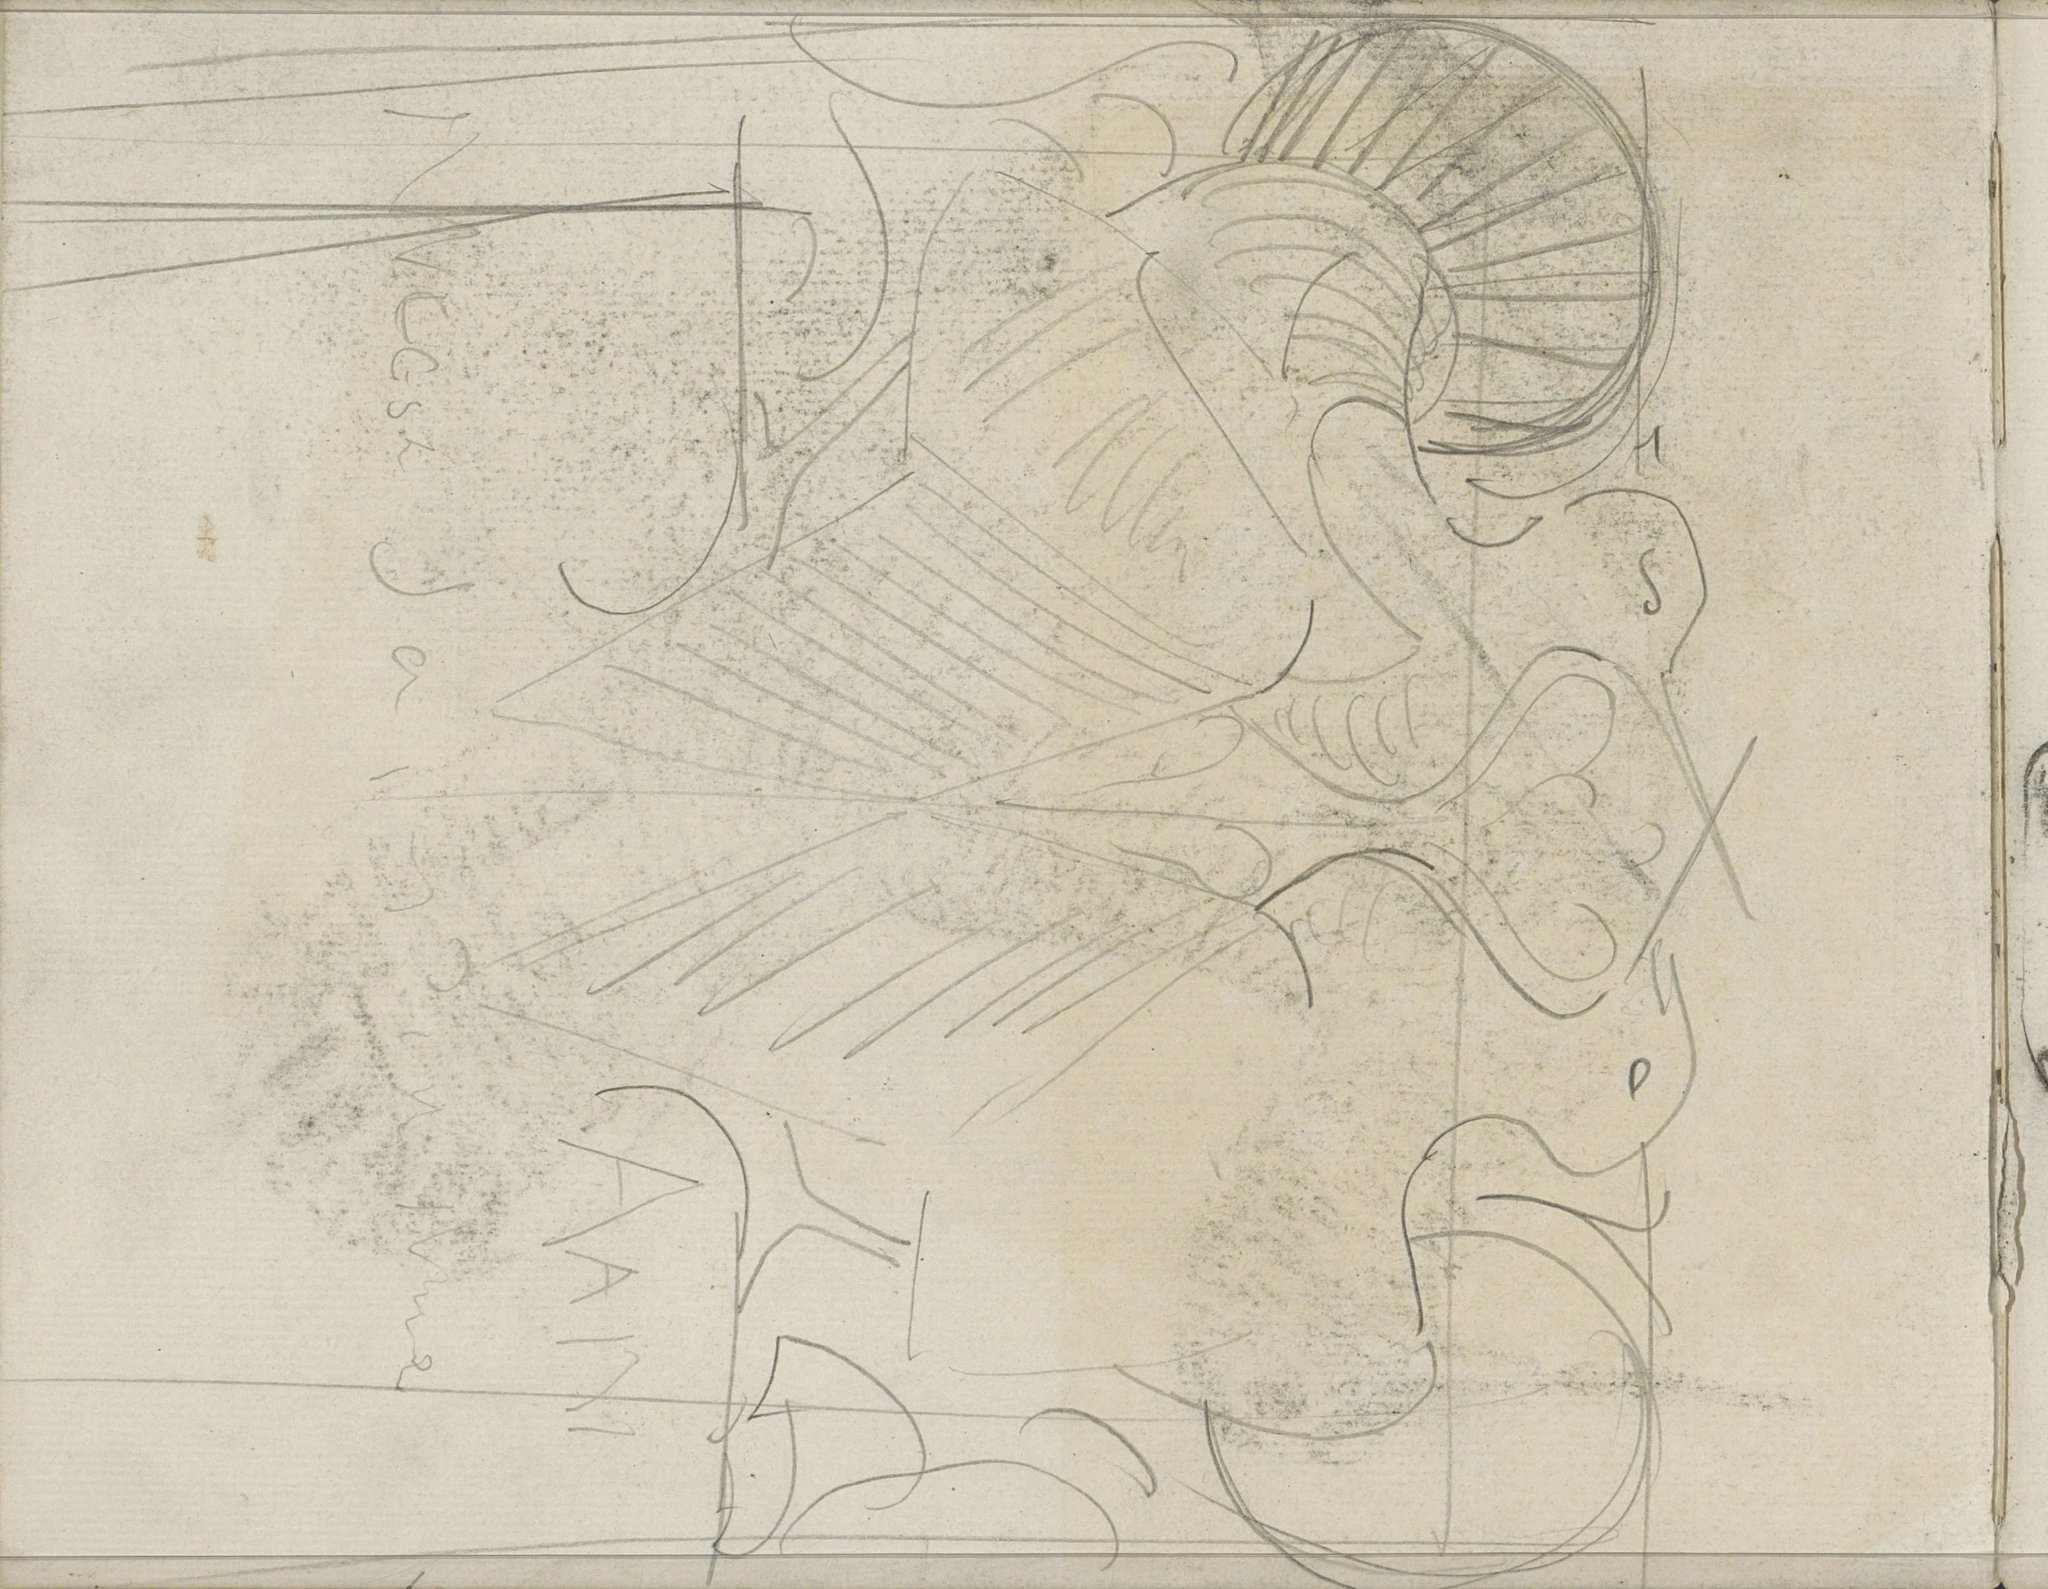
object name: sketchbook leaf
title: Ornament met vogels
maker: carel adolph lion cachet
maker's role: draughtsman, print maker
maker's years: 1864-1945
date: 1896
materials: paper, pencil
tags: ornament derived from animal forms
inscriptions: annotation: ‘AAN/ [...] Ja’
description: Blad 29 verso uit een schetsboek met 44 bladen.